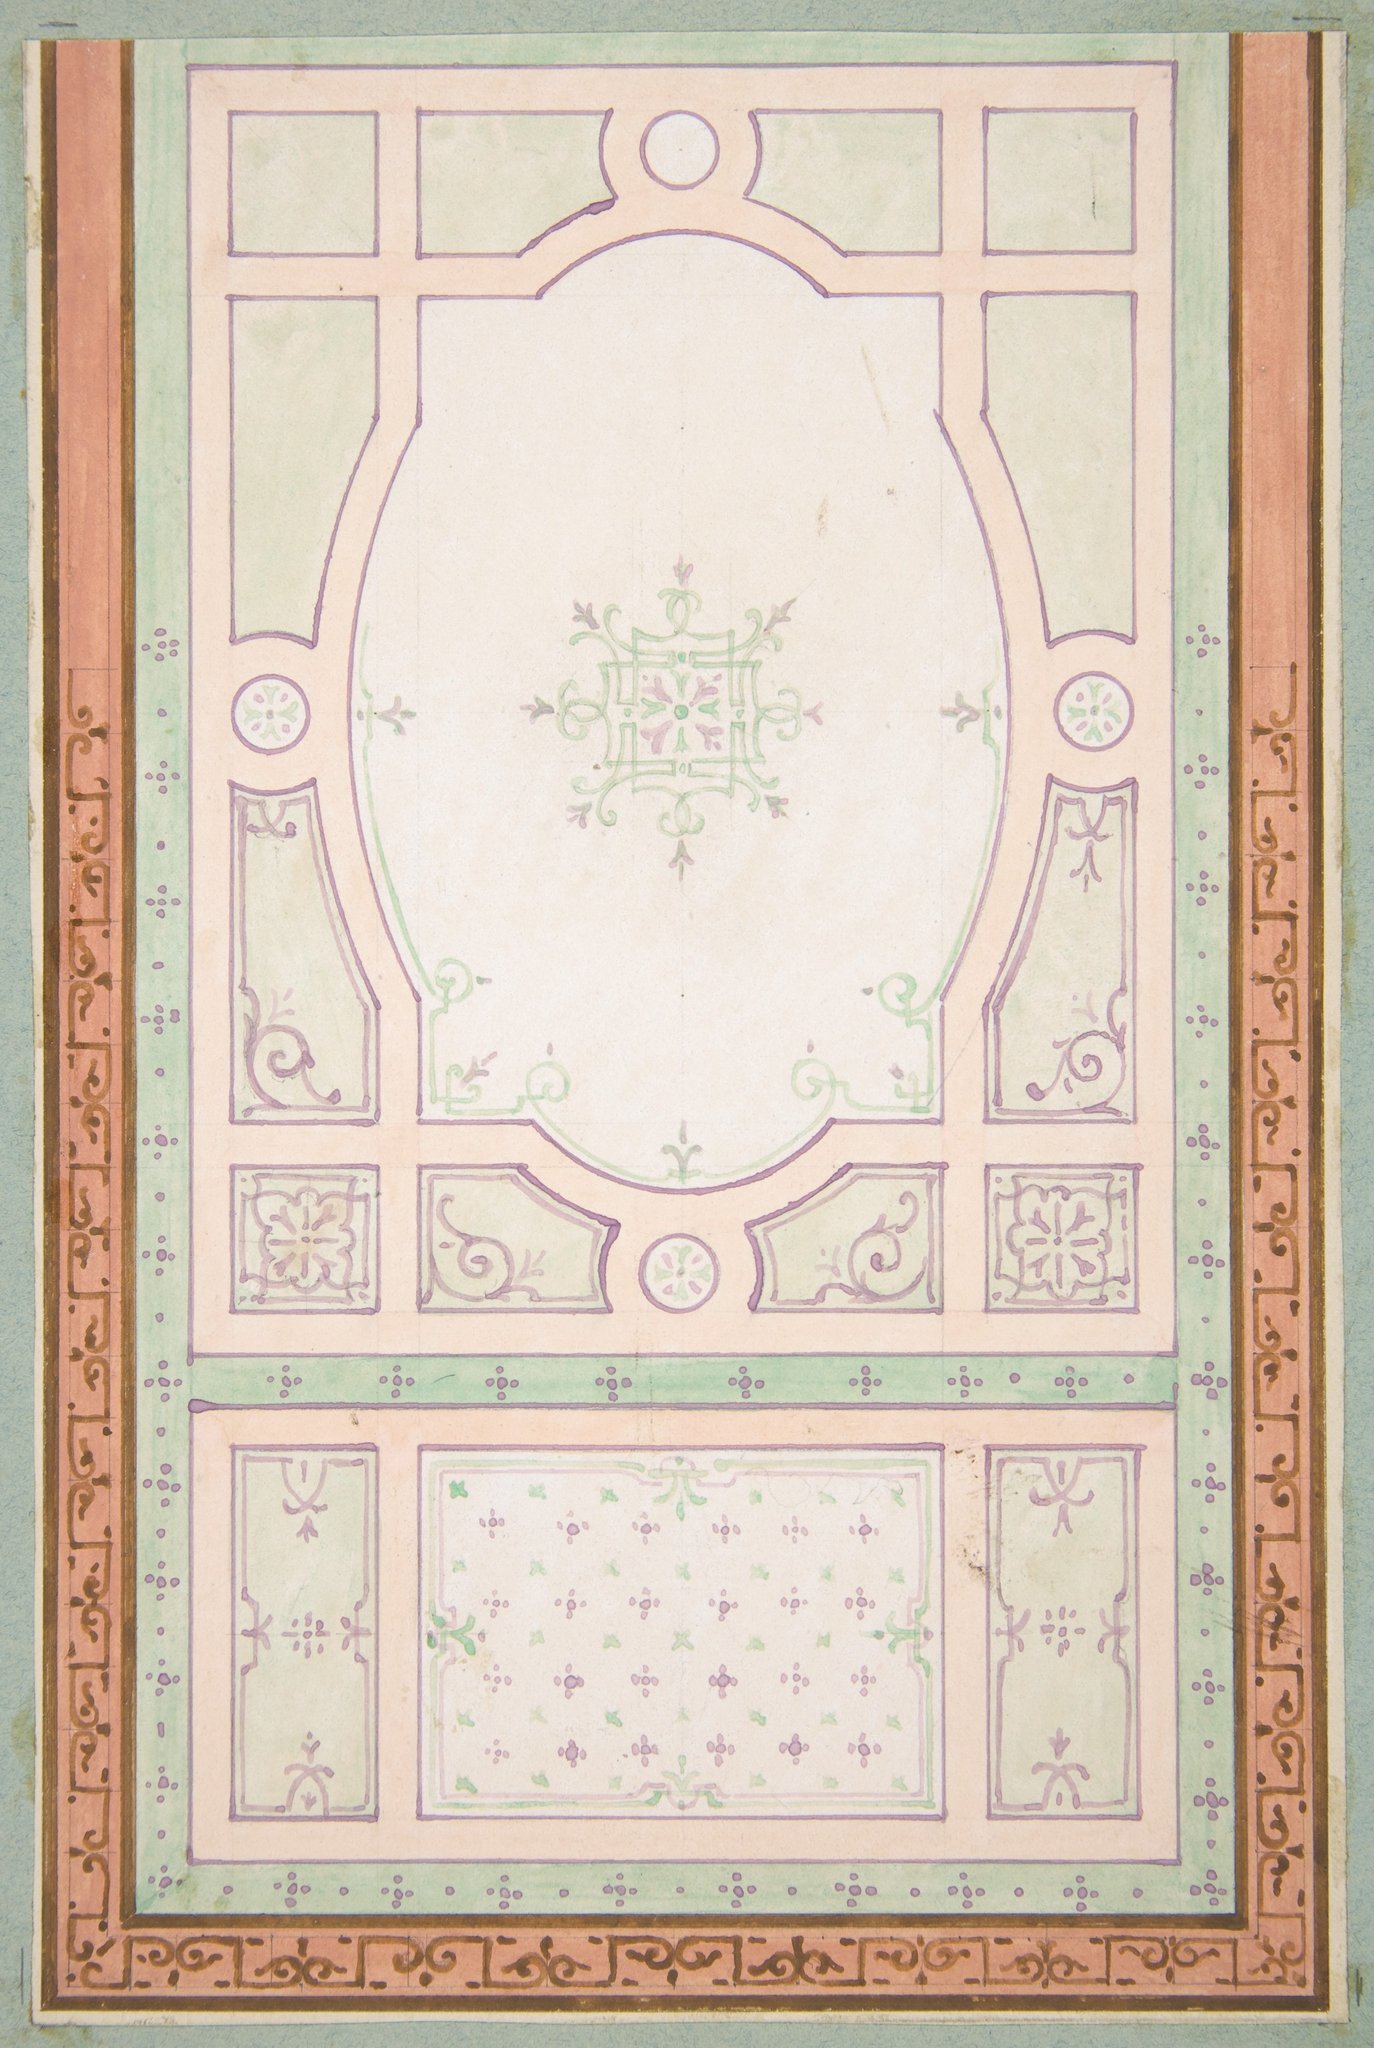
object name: drawing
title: Design for a ceiling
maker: jules-edmond-charles lachaise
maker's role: artist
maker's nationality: french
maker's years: 1897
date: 1851-1900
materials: graphite, watercolor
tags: architecture